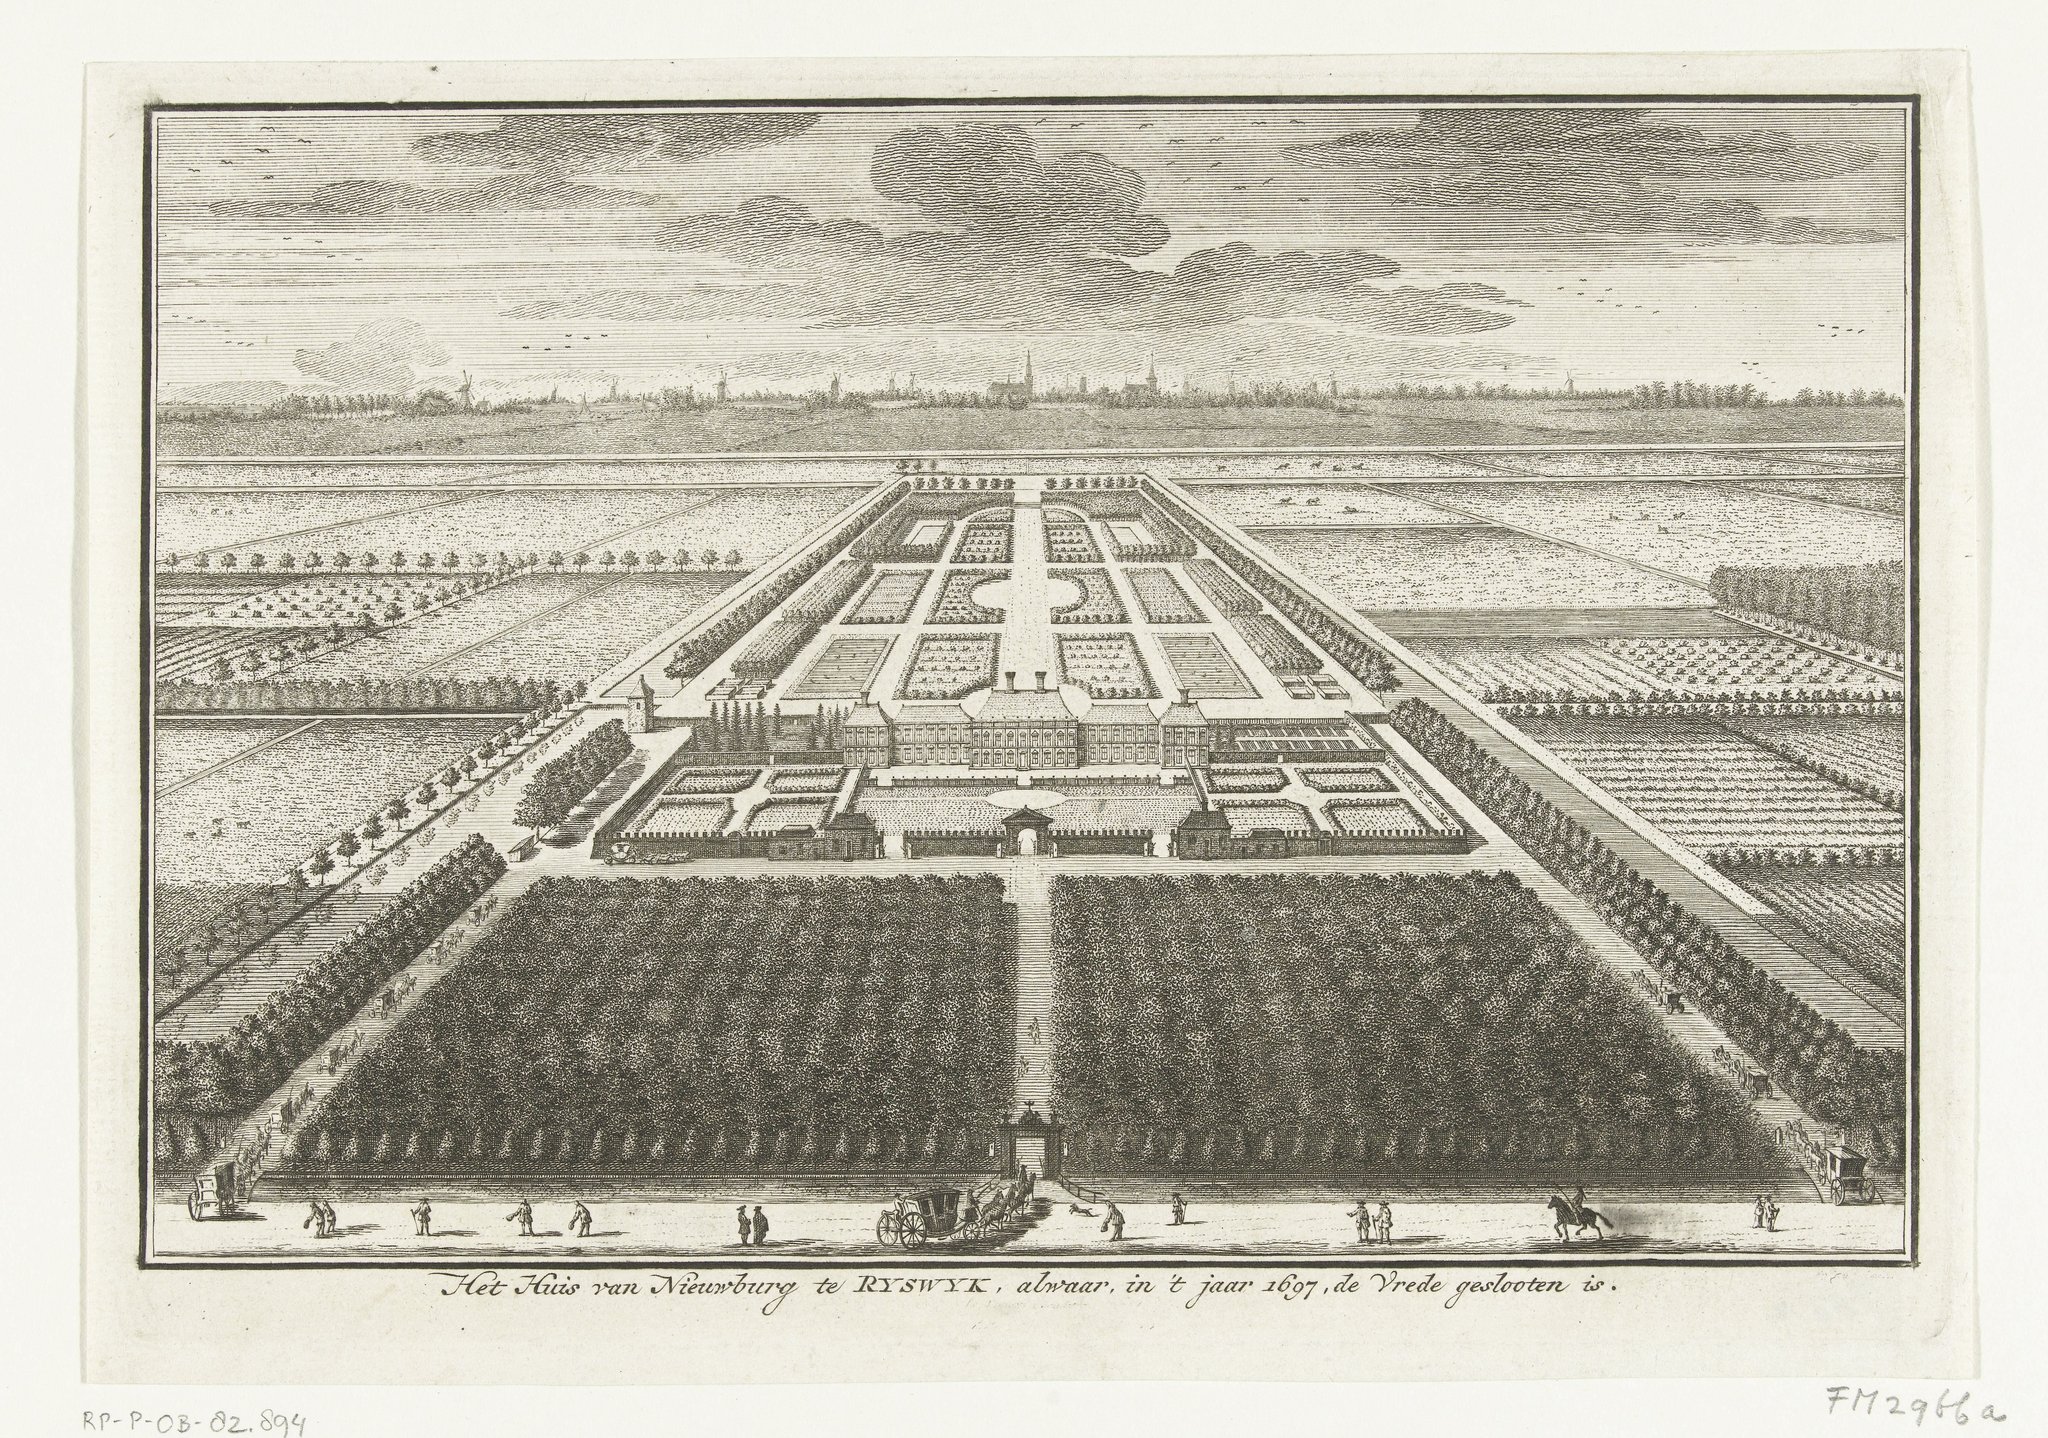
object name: print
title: Het Huis van Nieuwburg te Ryswyk, alwaar in 't jaar 1697, de Vrede geslooten is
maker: Anonymous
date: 1755-1757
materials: paper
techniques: etching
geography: northern netherlands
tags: garden, palace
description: Gezicht in vogelvluchtperspectief op het Huis ter Nieuburch met de tuinen te Rijswijk. Op de voorgrond de weg uit Den Haag met de drie bruggen en de drie aparte ingangen tot het paleis, in het verschiet Delft.